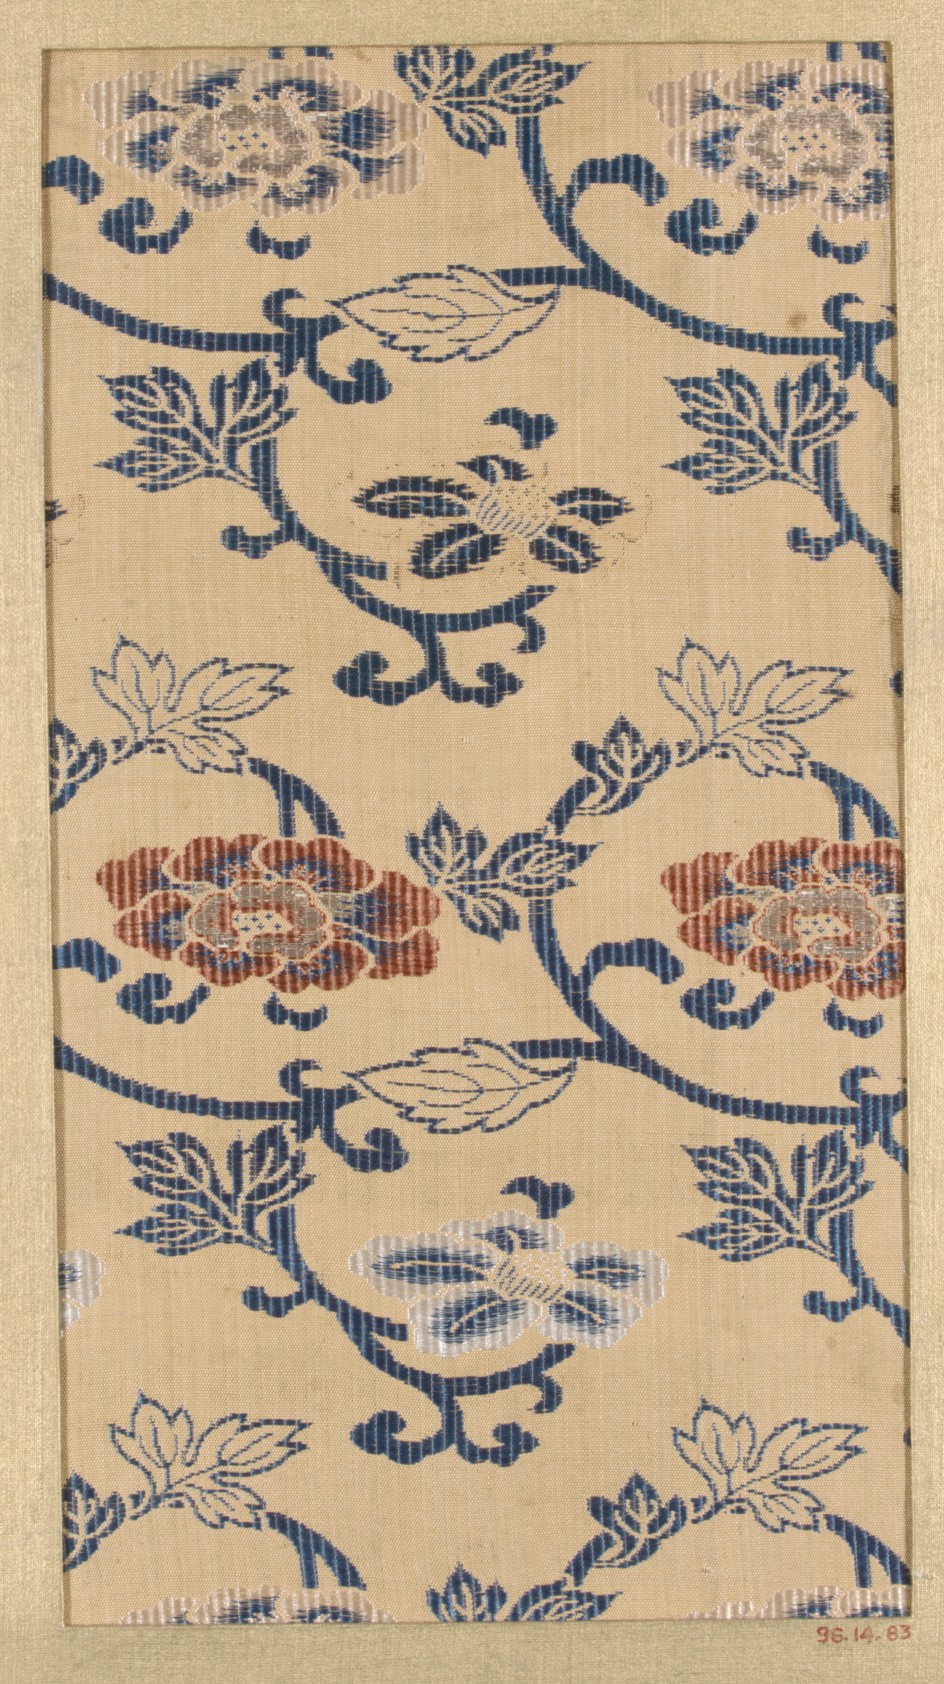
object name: piece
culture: japanese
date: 1701-1900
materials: silk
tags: leaves